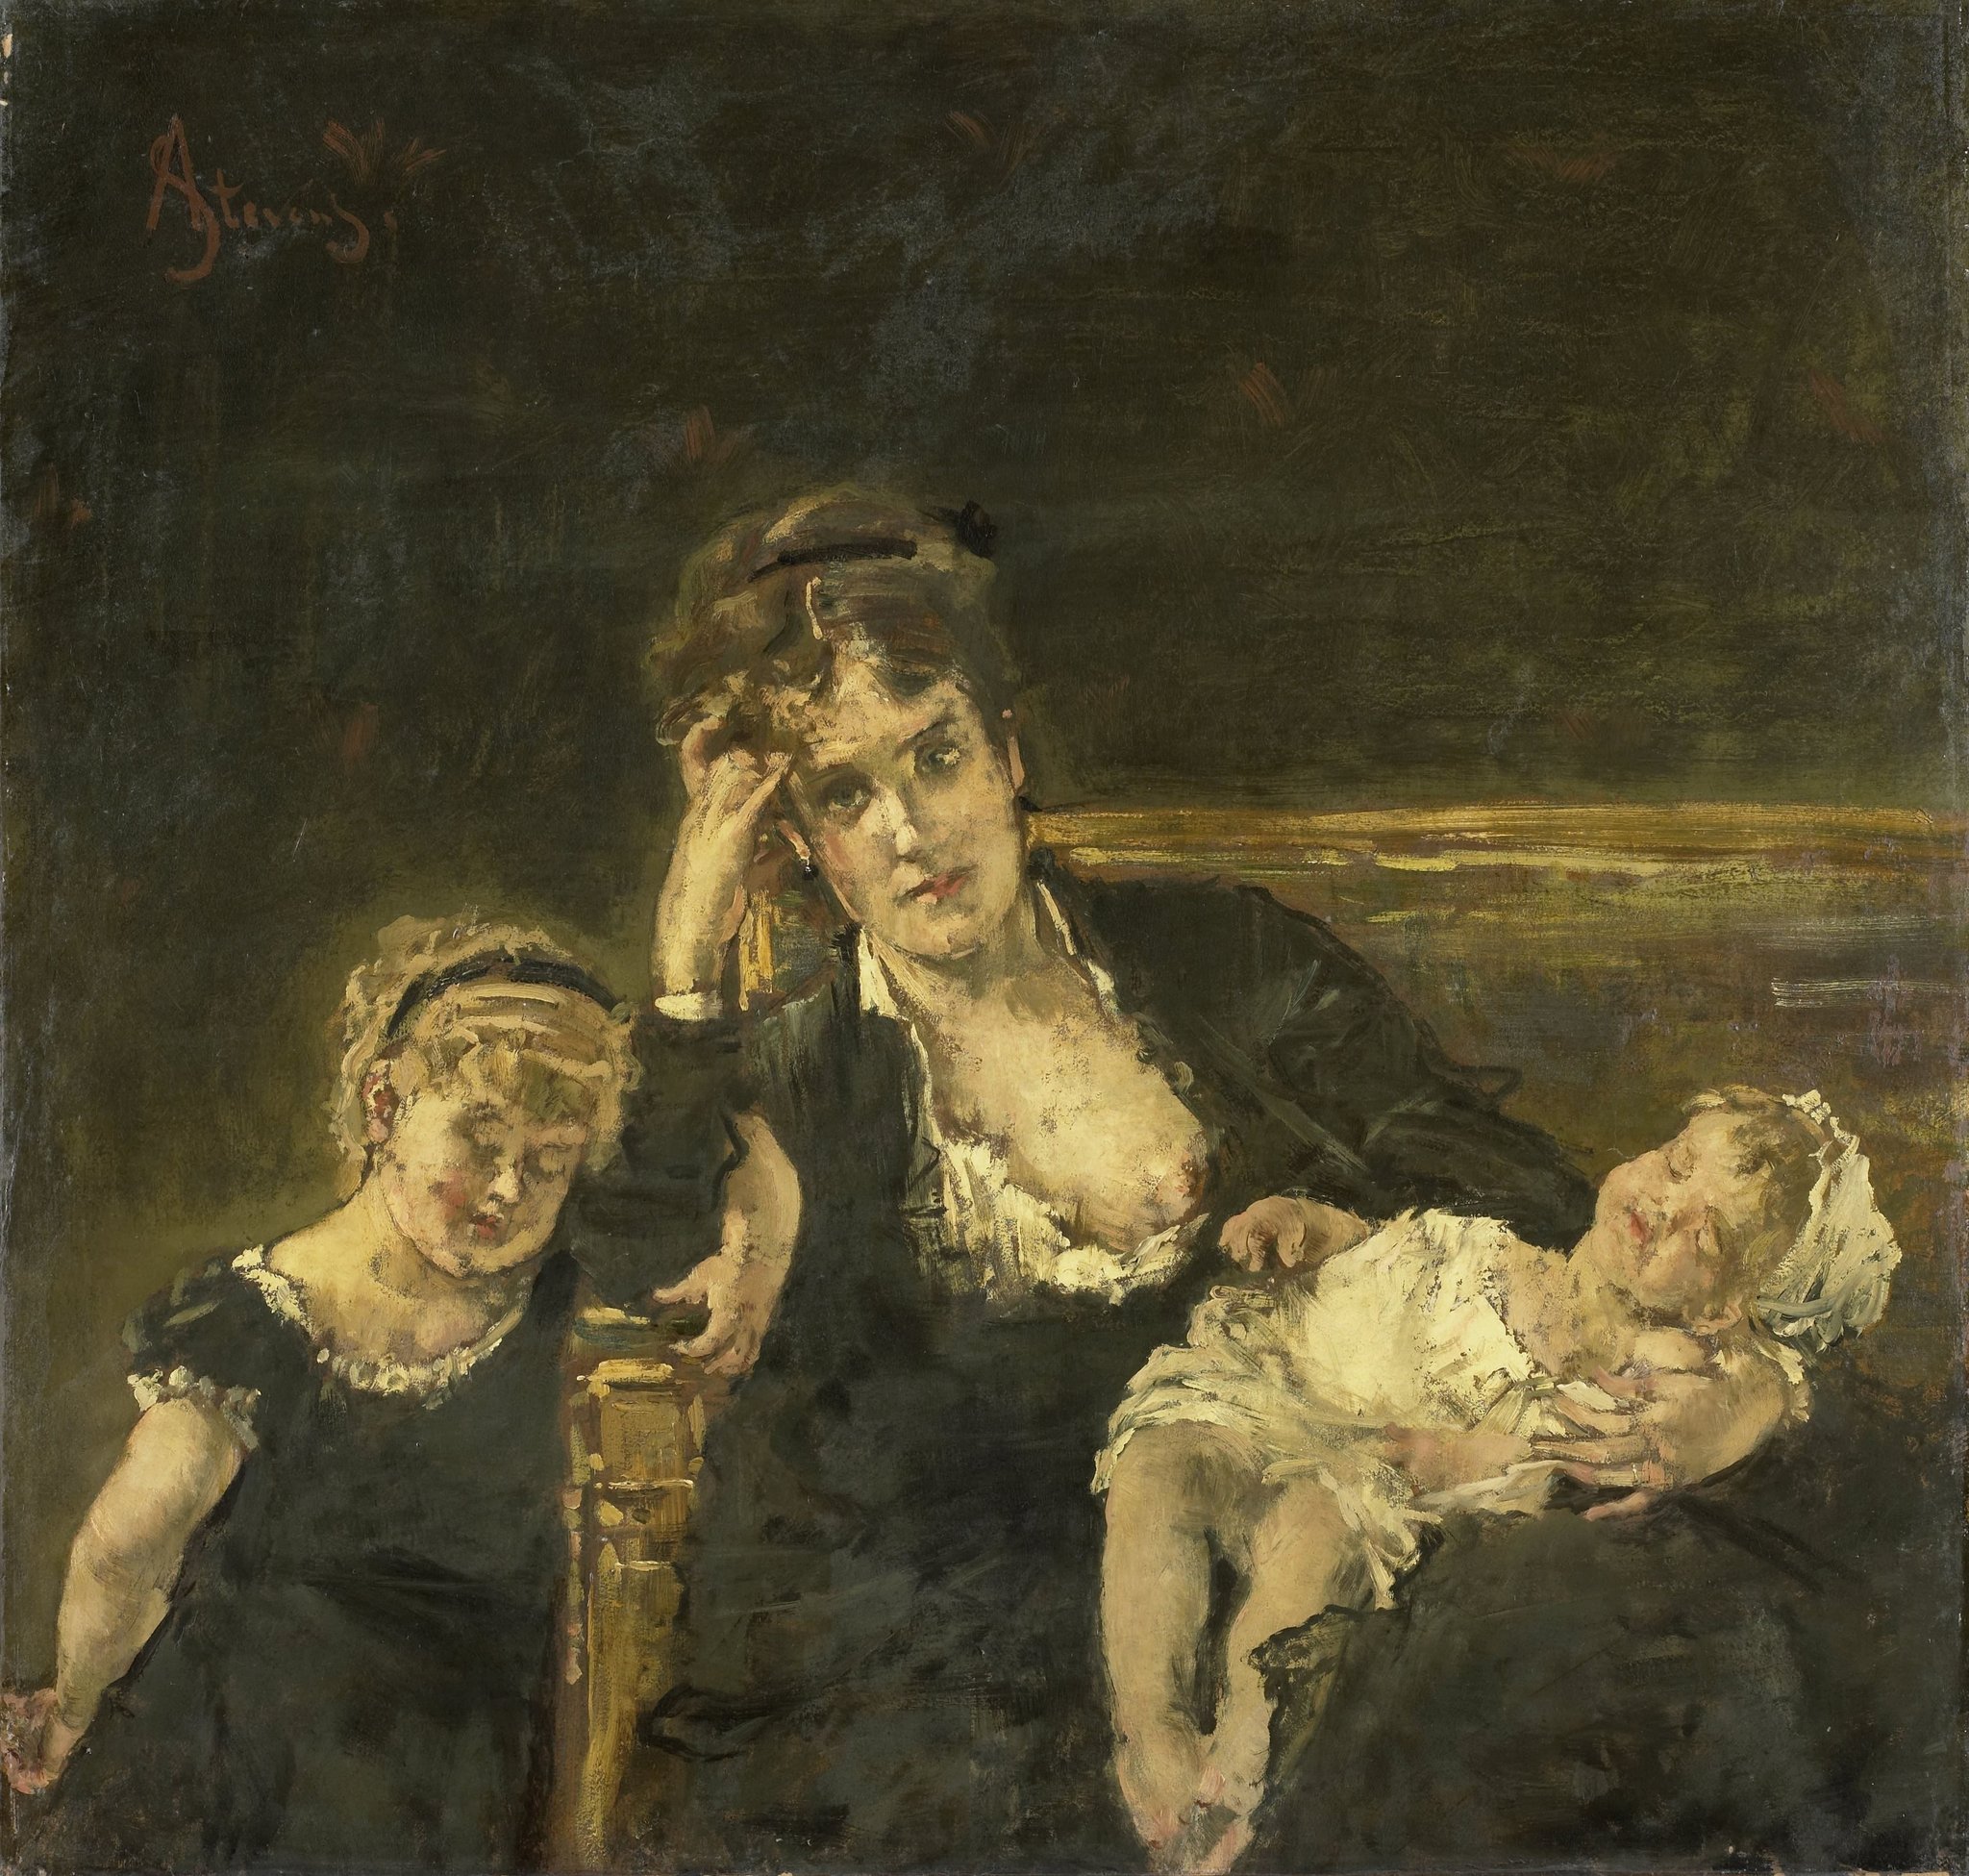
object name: painting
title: De weduwe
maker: alfred stevens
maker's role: painter, print maker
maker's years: 1823-1906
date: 1850-1906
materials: canvas, oil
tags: mother with daughter(s) (mother-love), mother and baby or young child, widow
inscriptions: signature: ‘AStevens.’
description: De weduwe. Een jonge moeder zittend op een sofa met een kind op schoot, links leunt een meisje tegen haar aan.